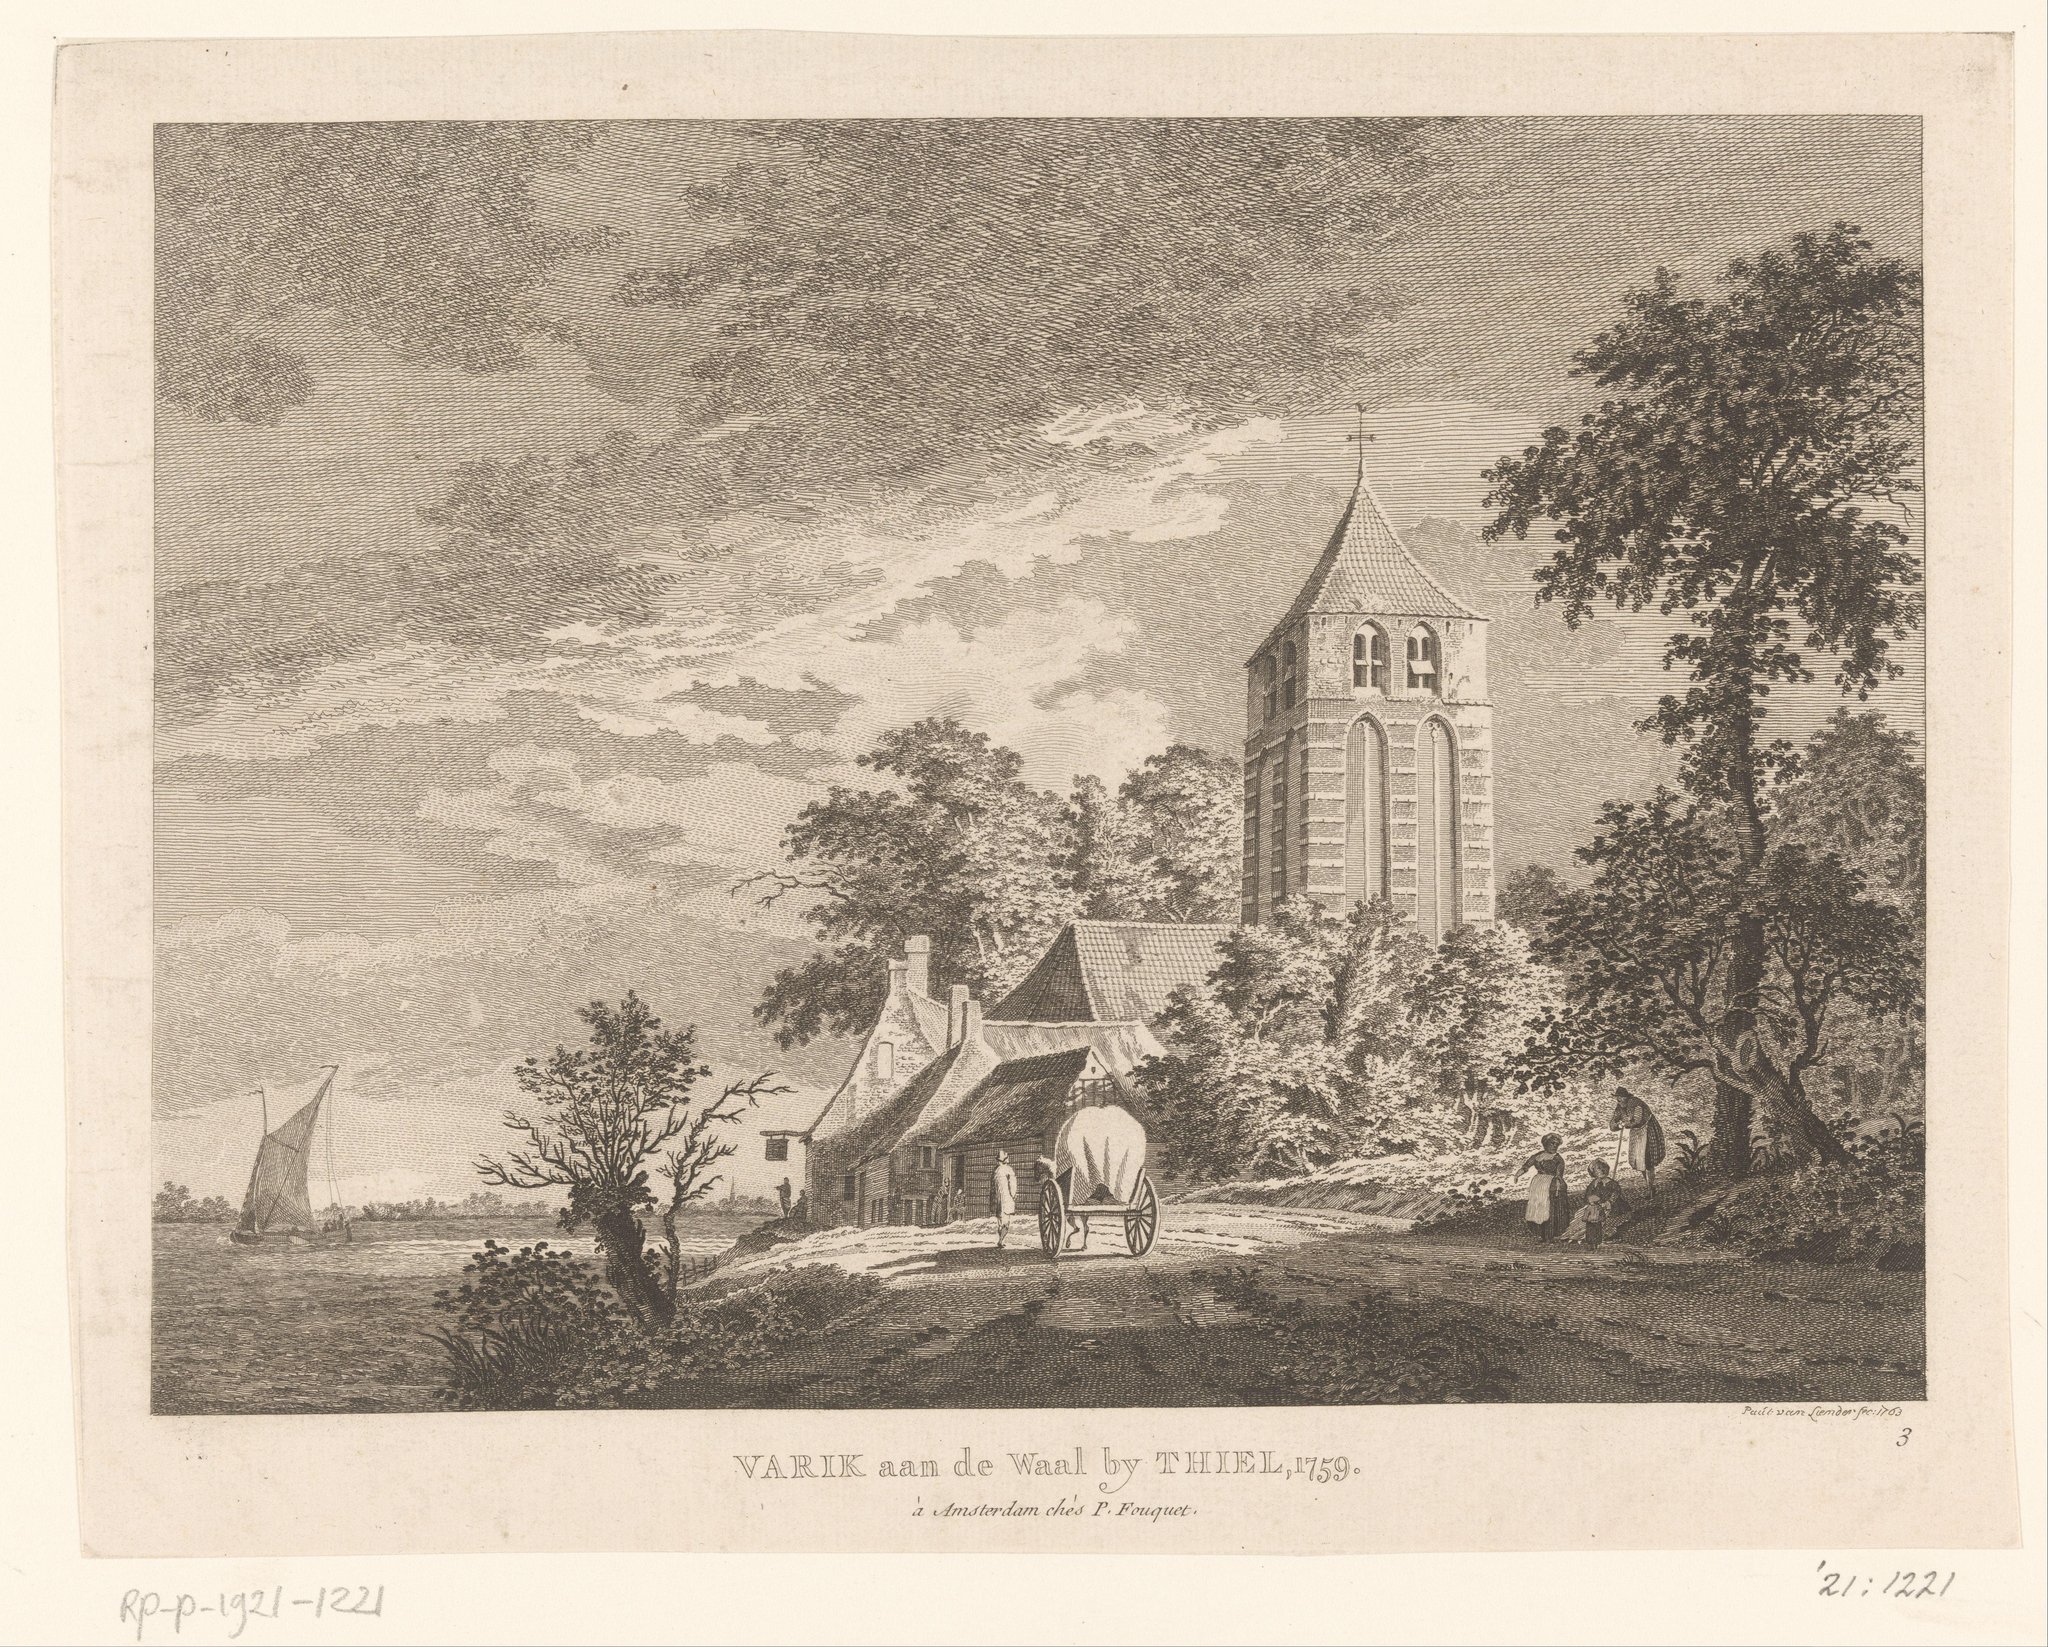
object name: print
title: Dorpsgezicht te Varik, 1759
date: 1763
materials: paper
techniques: etching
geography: amsterdam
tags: river, village, church (exterior)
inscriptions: collector's mark: Lugt 2233